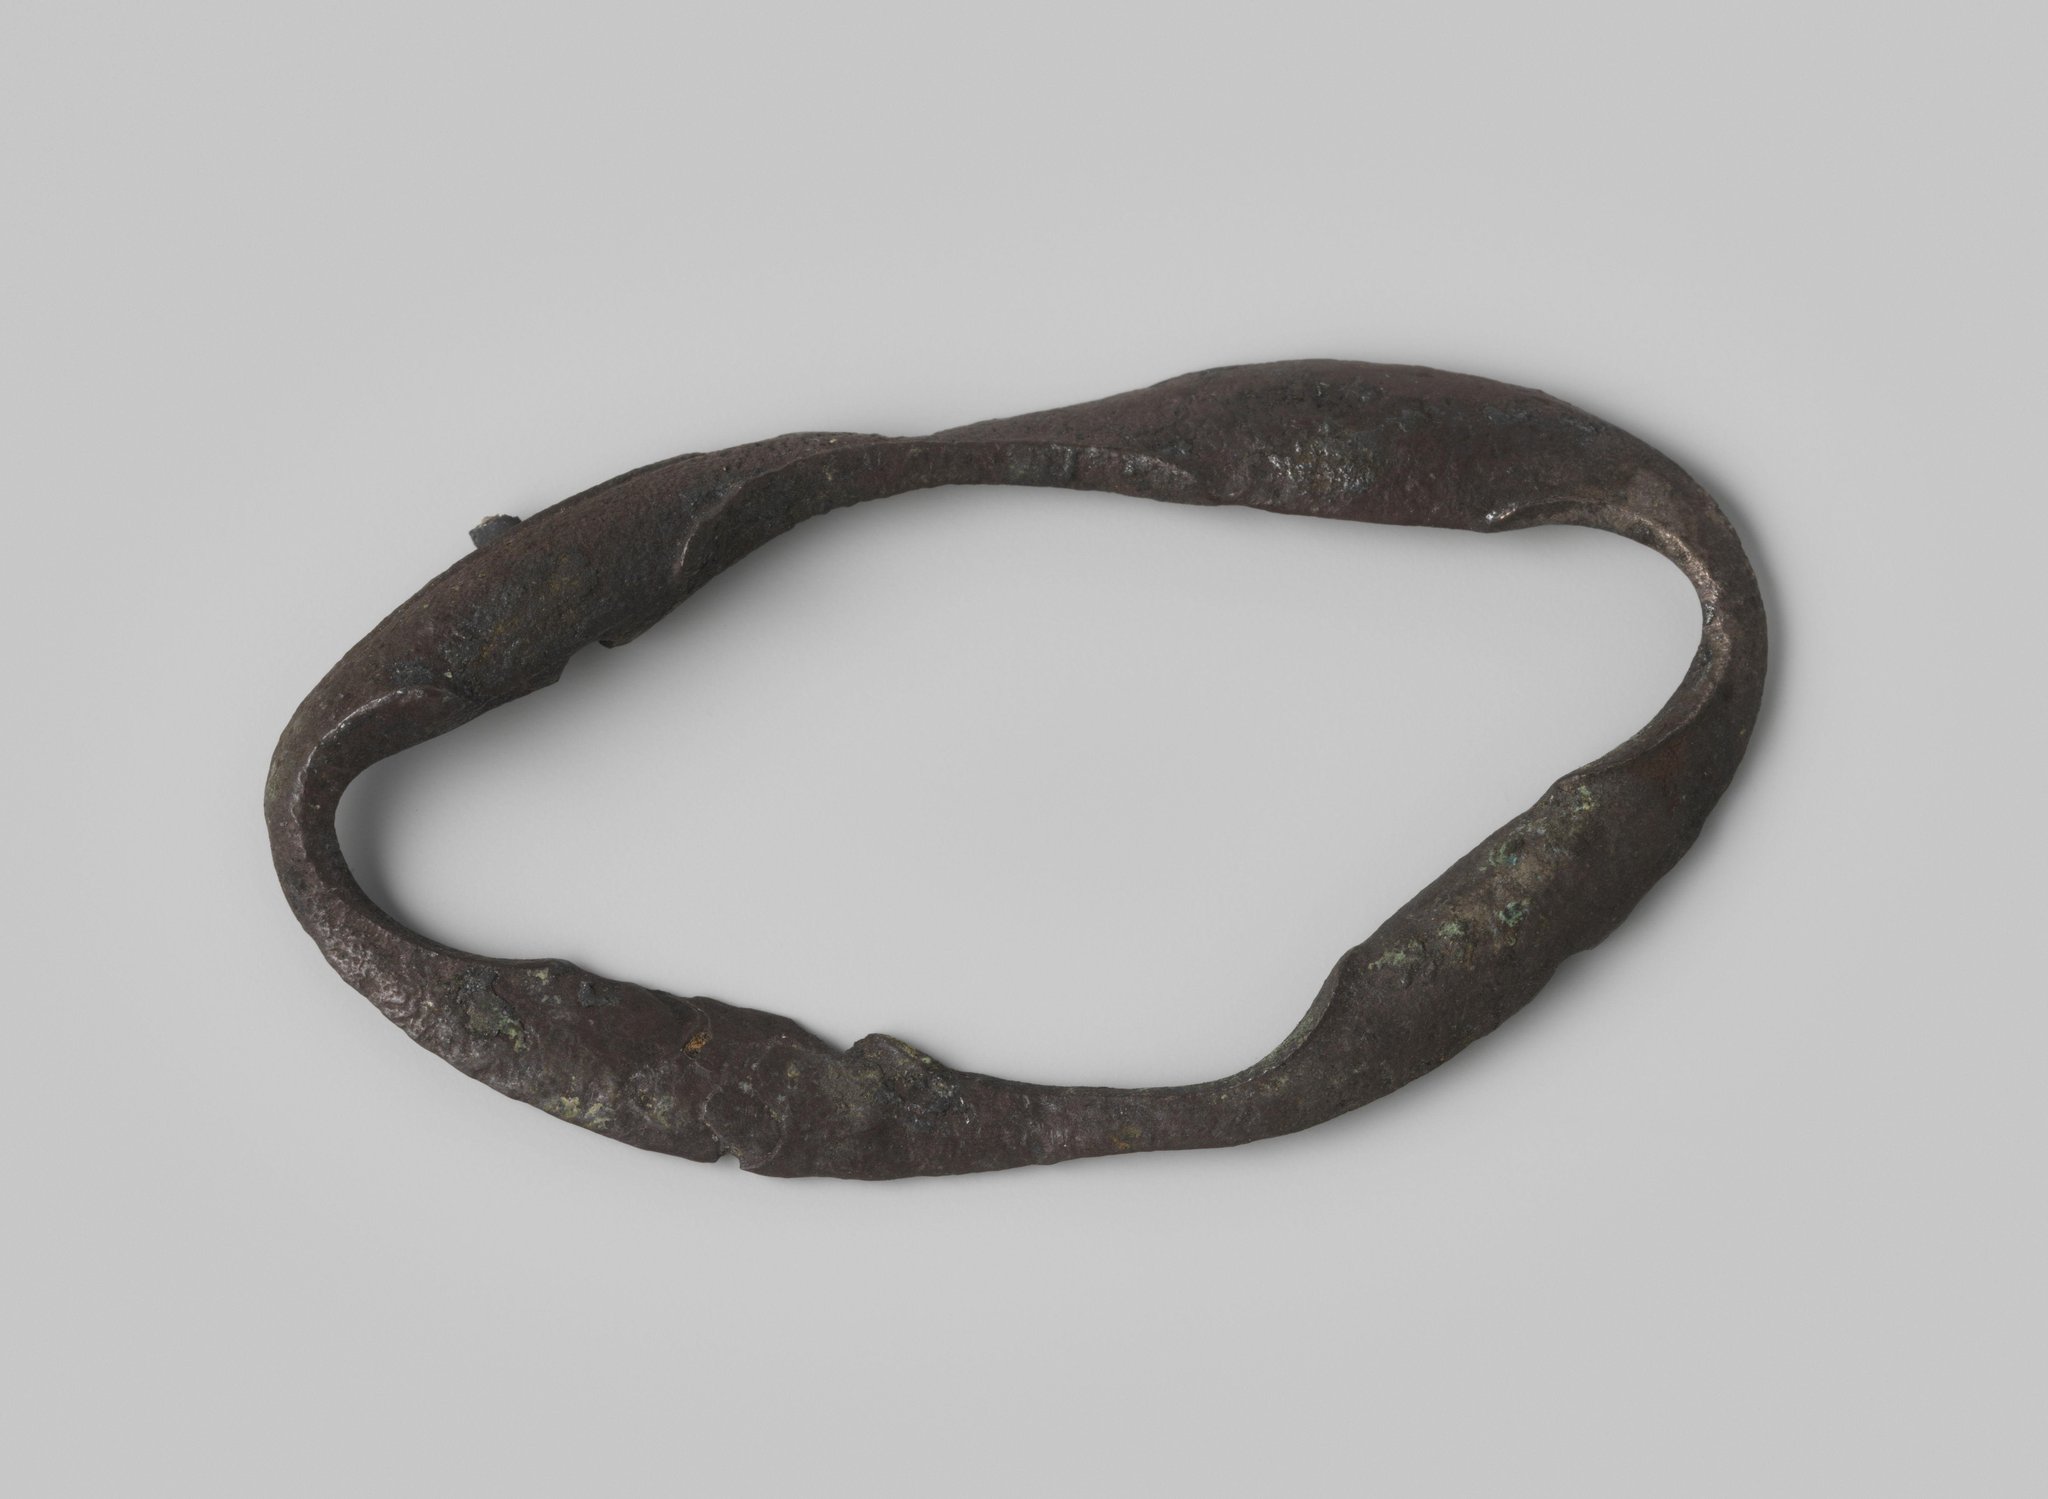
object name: buckle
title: Gesp uit het wrak van de Oost-Indiëvaarder Hollandia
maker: Anonymous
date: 1700-1743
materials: silver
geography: netherlands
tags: verenigde oostindische compagnie, hollandia (schip), annet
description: Buckle, not identifiable; ring, squashed, flat, moulded corners.